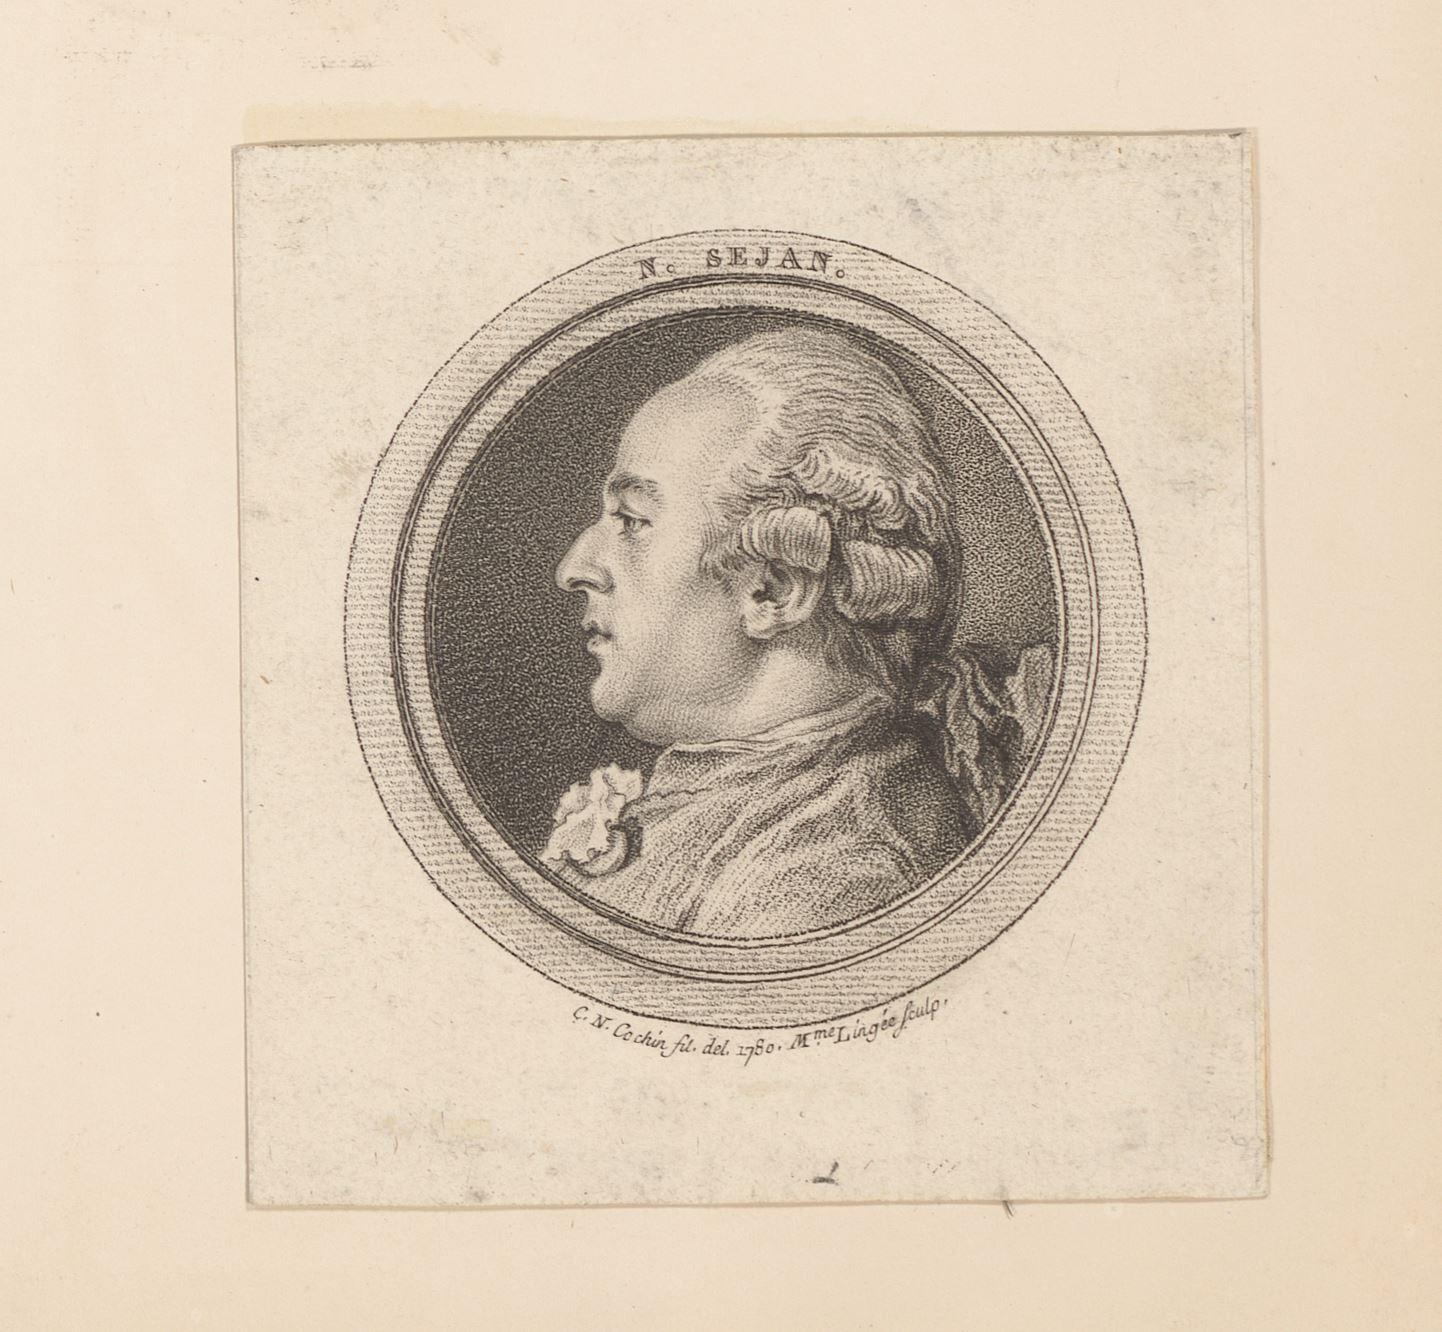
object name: album leaf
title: N. Sejan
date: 1780-1790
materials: paper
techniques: etching, roulette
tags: paris, historical persons, portrait of composer